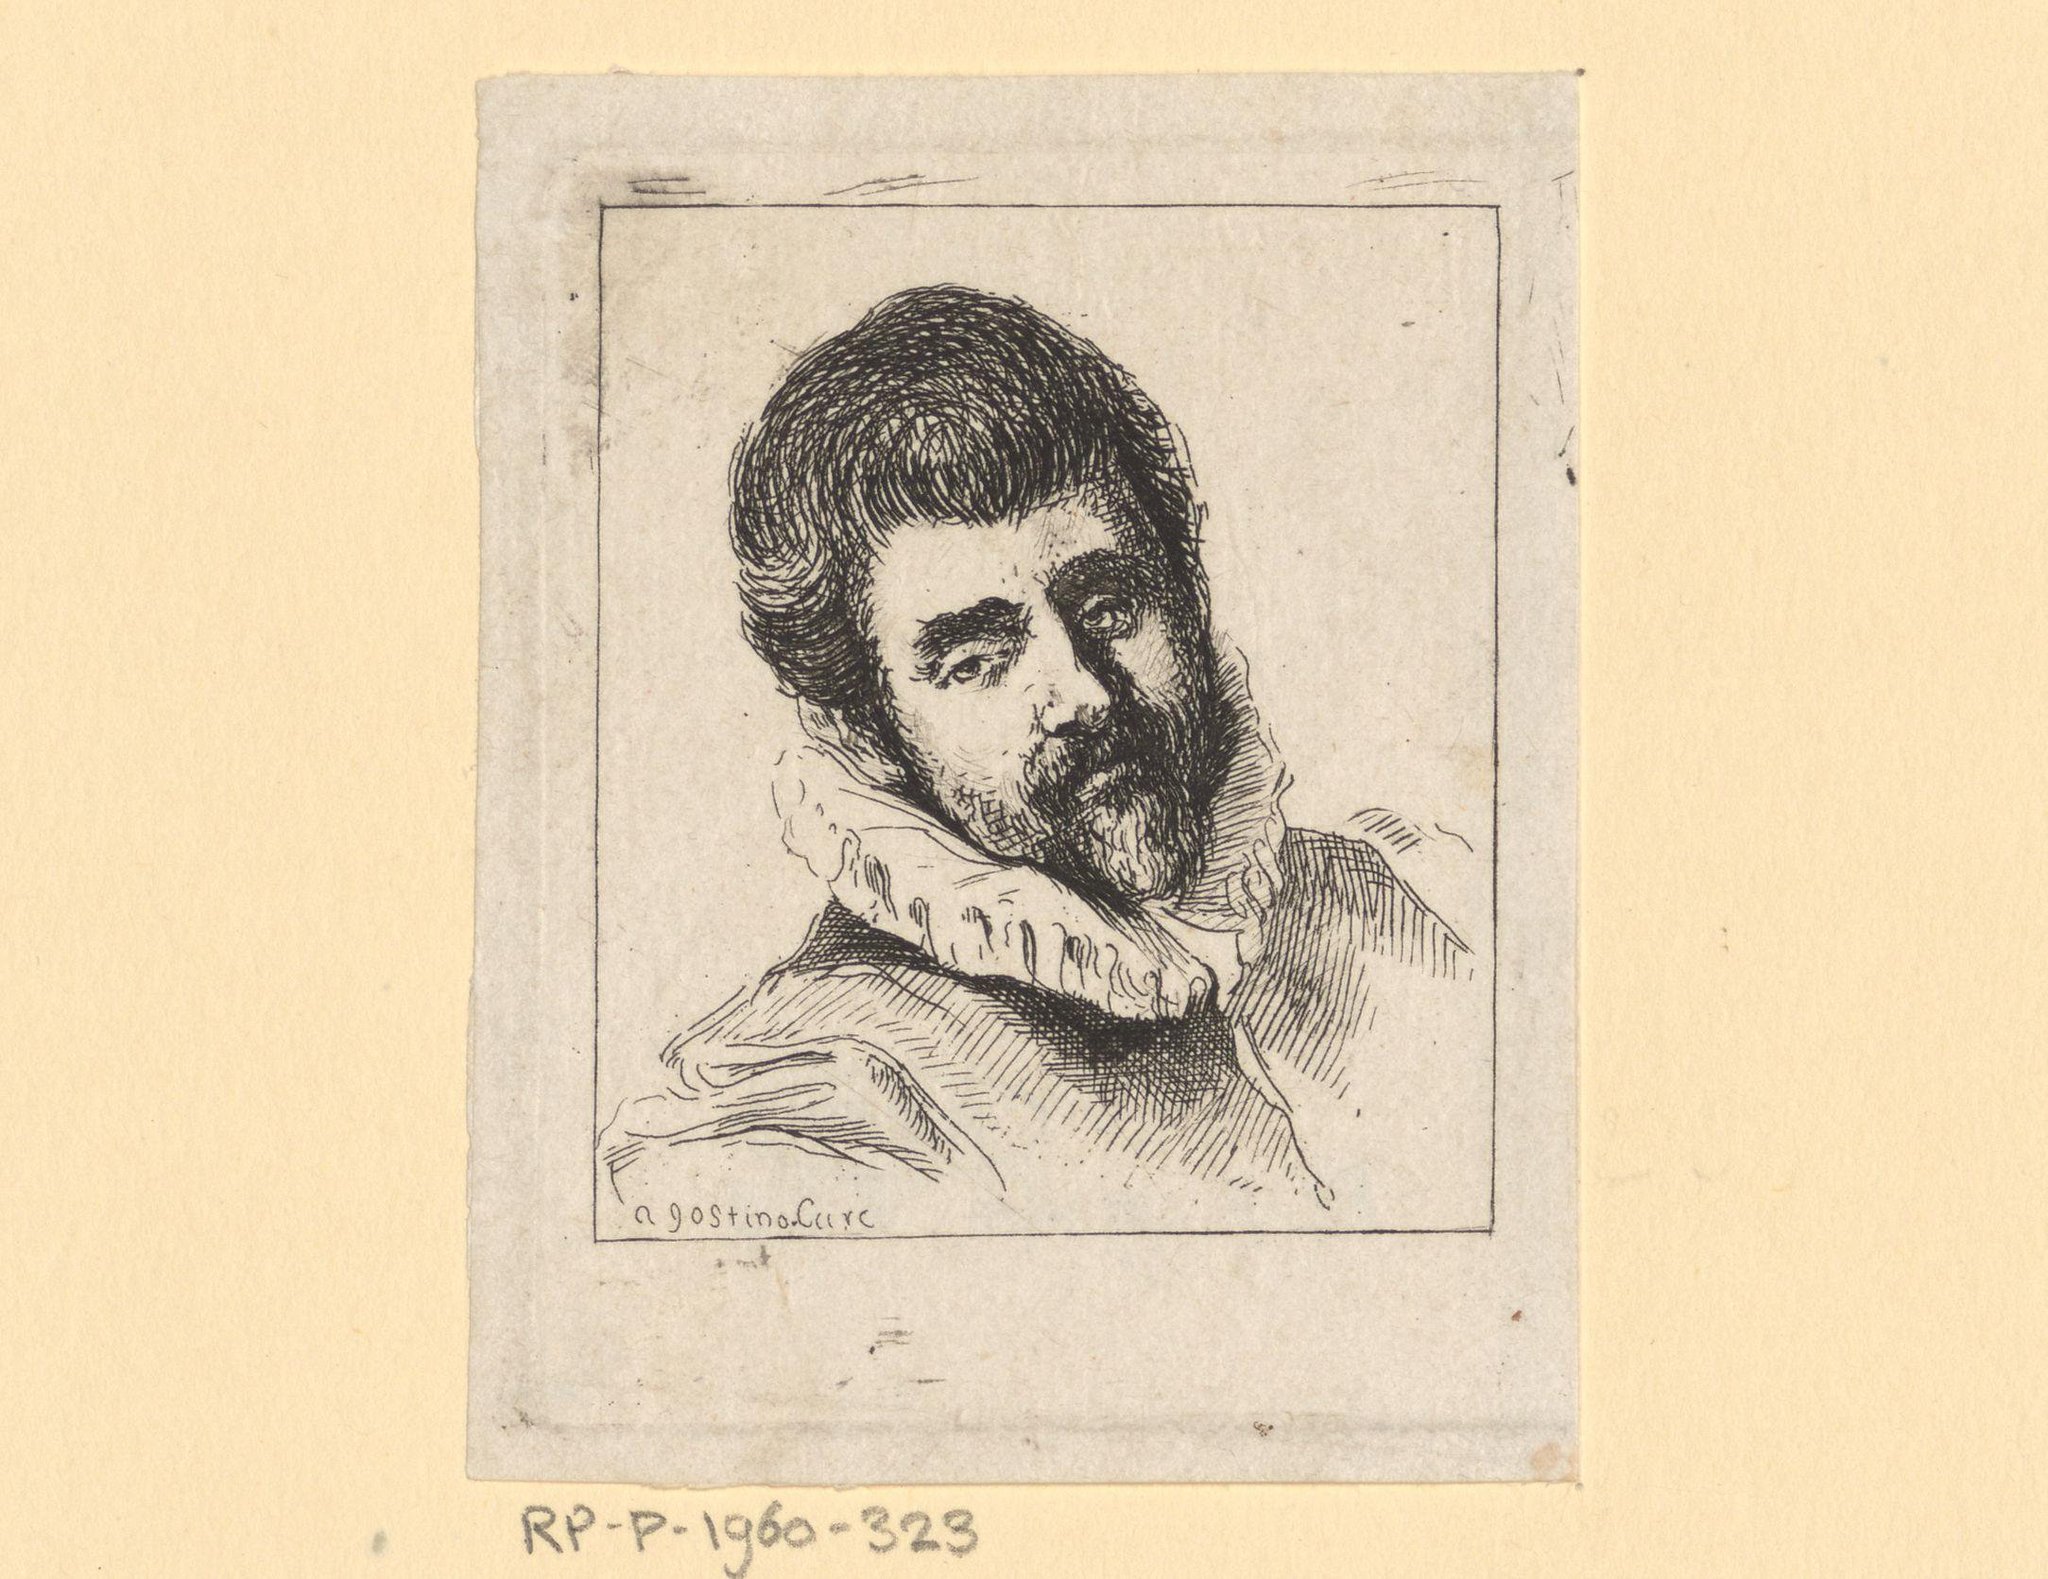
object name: print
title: Portret van Agostino Carracci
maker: Anonymous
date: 1700-1799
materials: paper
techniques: etching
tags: painter, draughtsman, agostino carracci, portrait, self-portrait of painter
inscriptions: collector's mark: Lugt 2282